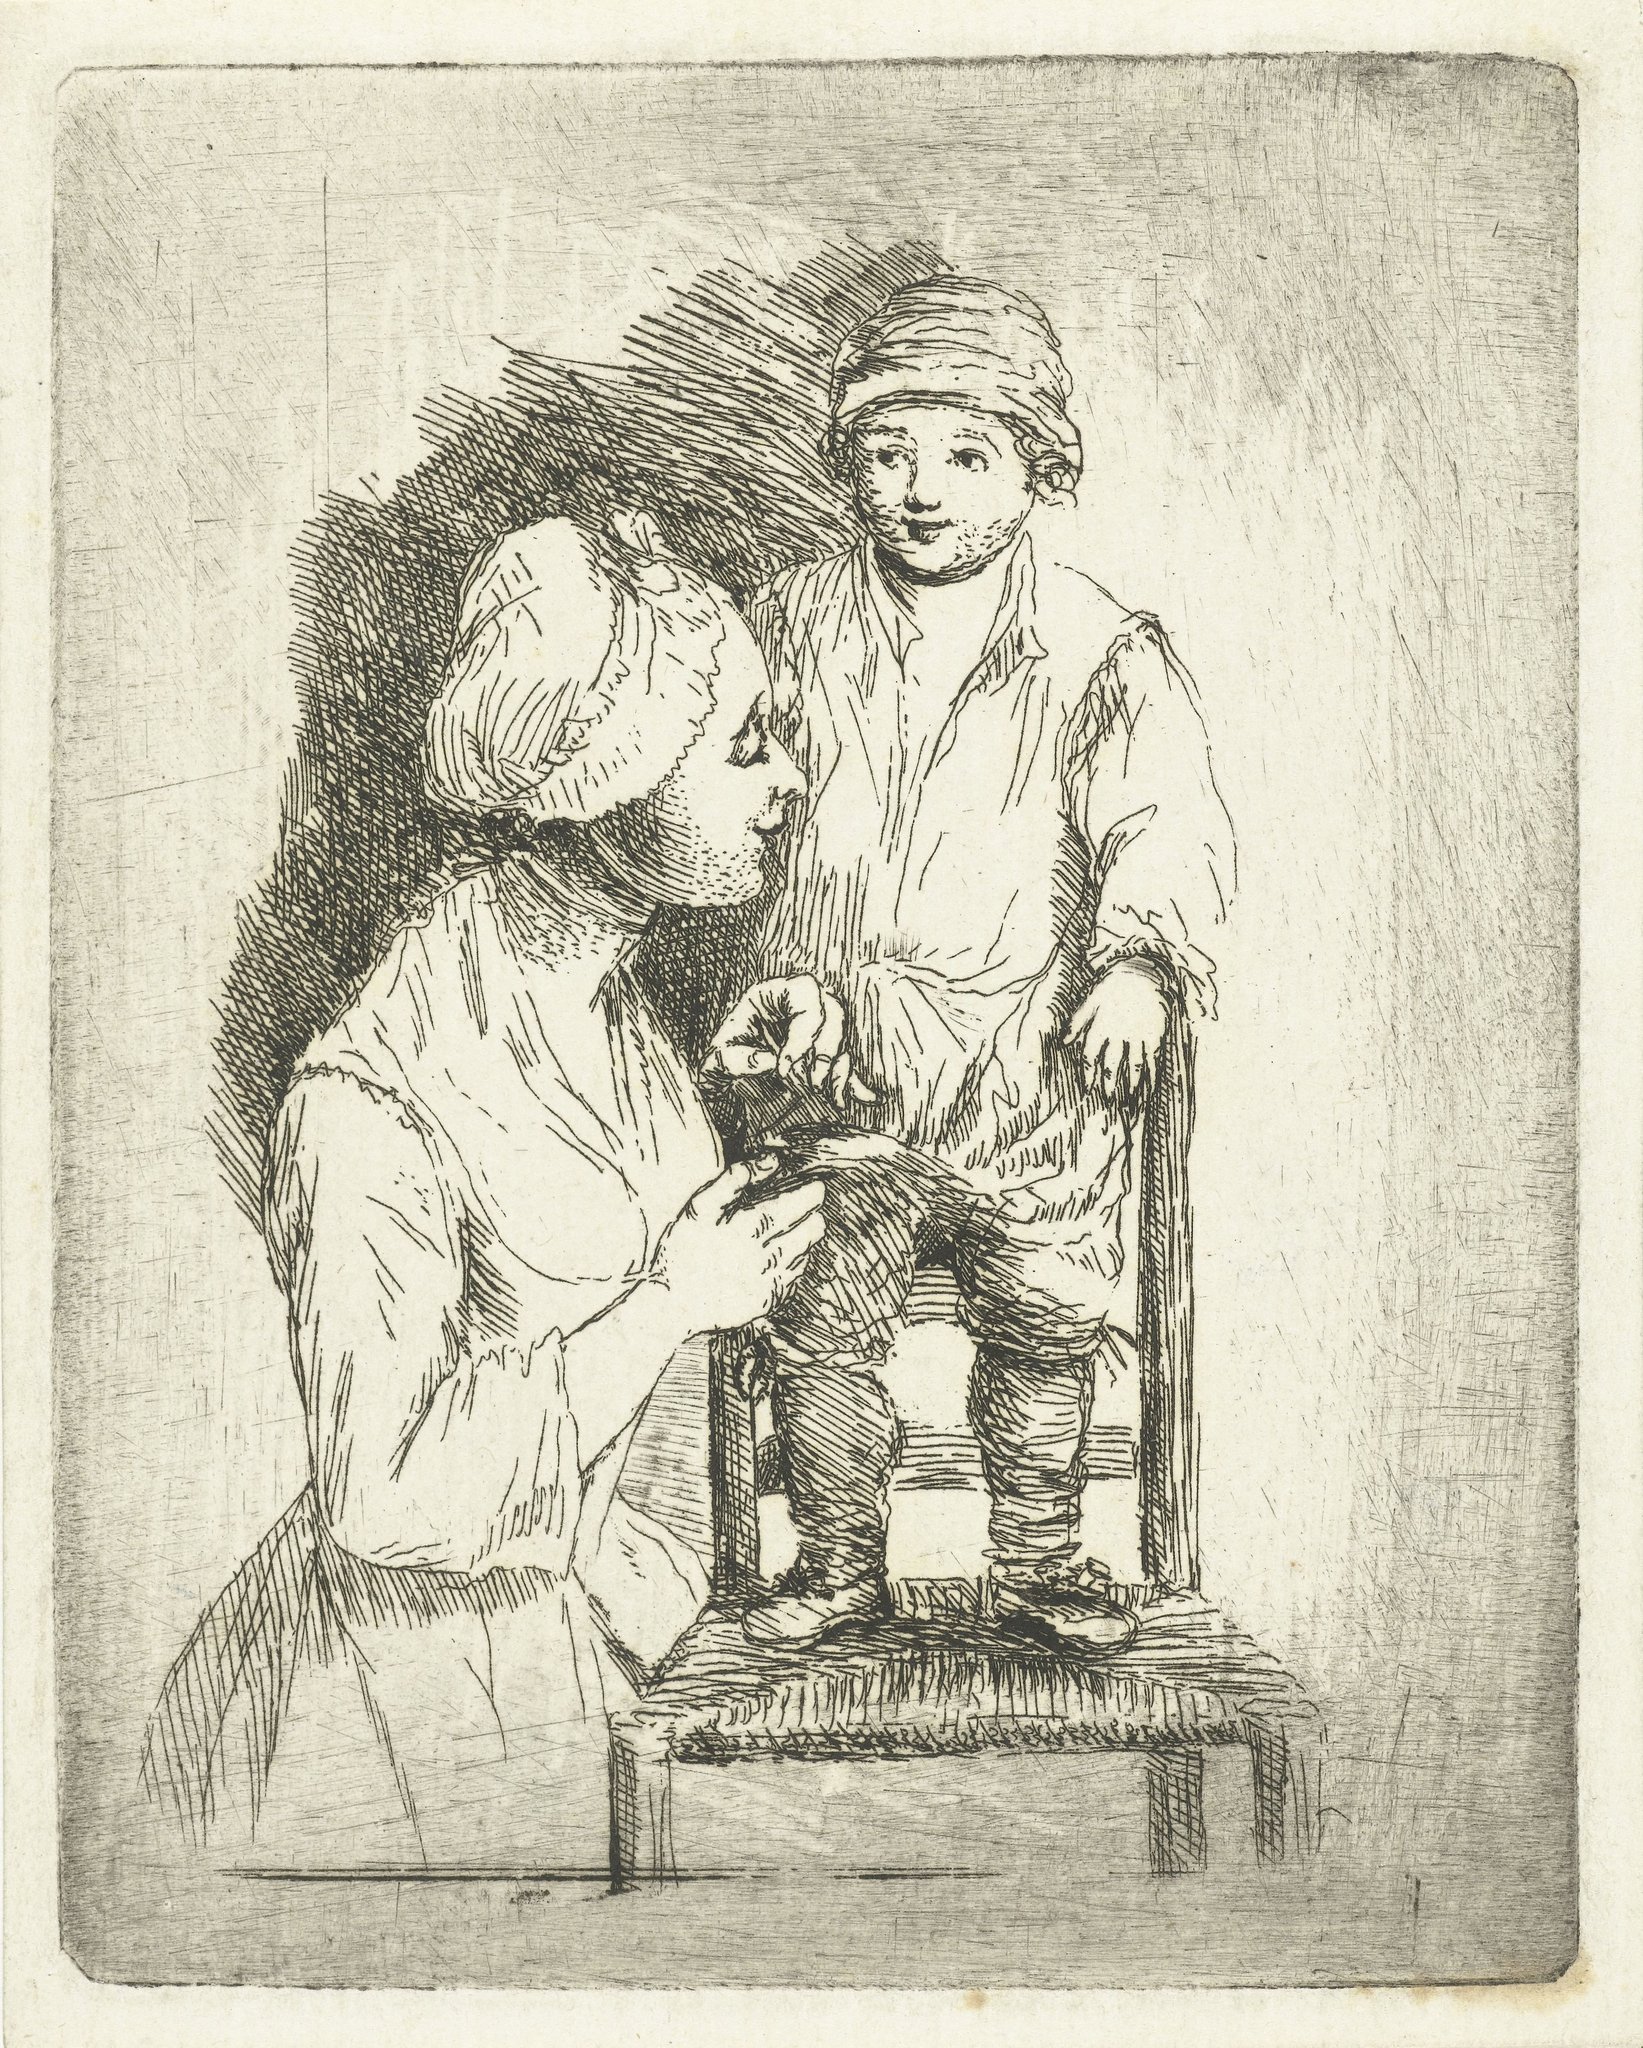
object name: print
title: Een moeder zet een knoop aan de broek van haar zoon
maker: louis bernard coclers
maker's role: draughtsman, print maker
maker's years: 1741-1817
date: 1756-1817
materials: paper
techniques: drypoint, etching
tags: mother and son(s) (family group), home sewing; repair of clothes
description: Een jongetje staat op een stoel. Zijn moeder is bezig met naald en draad een knoop vast te zetten aan zijn broek.